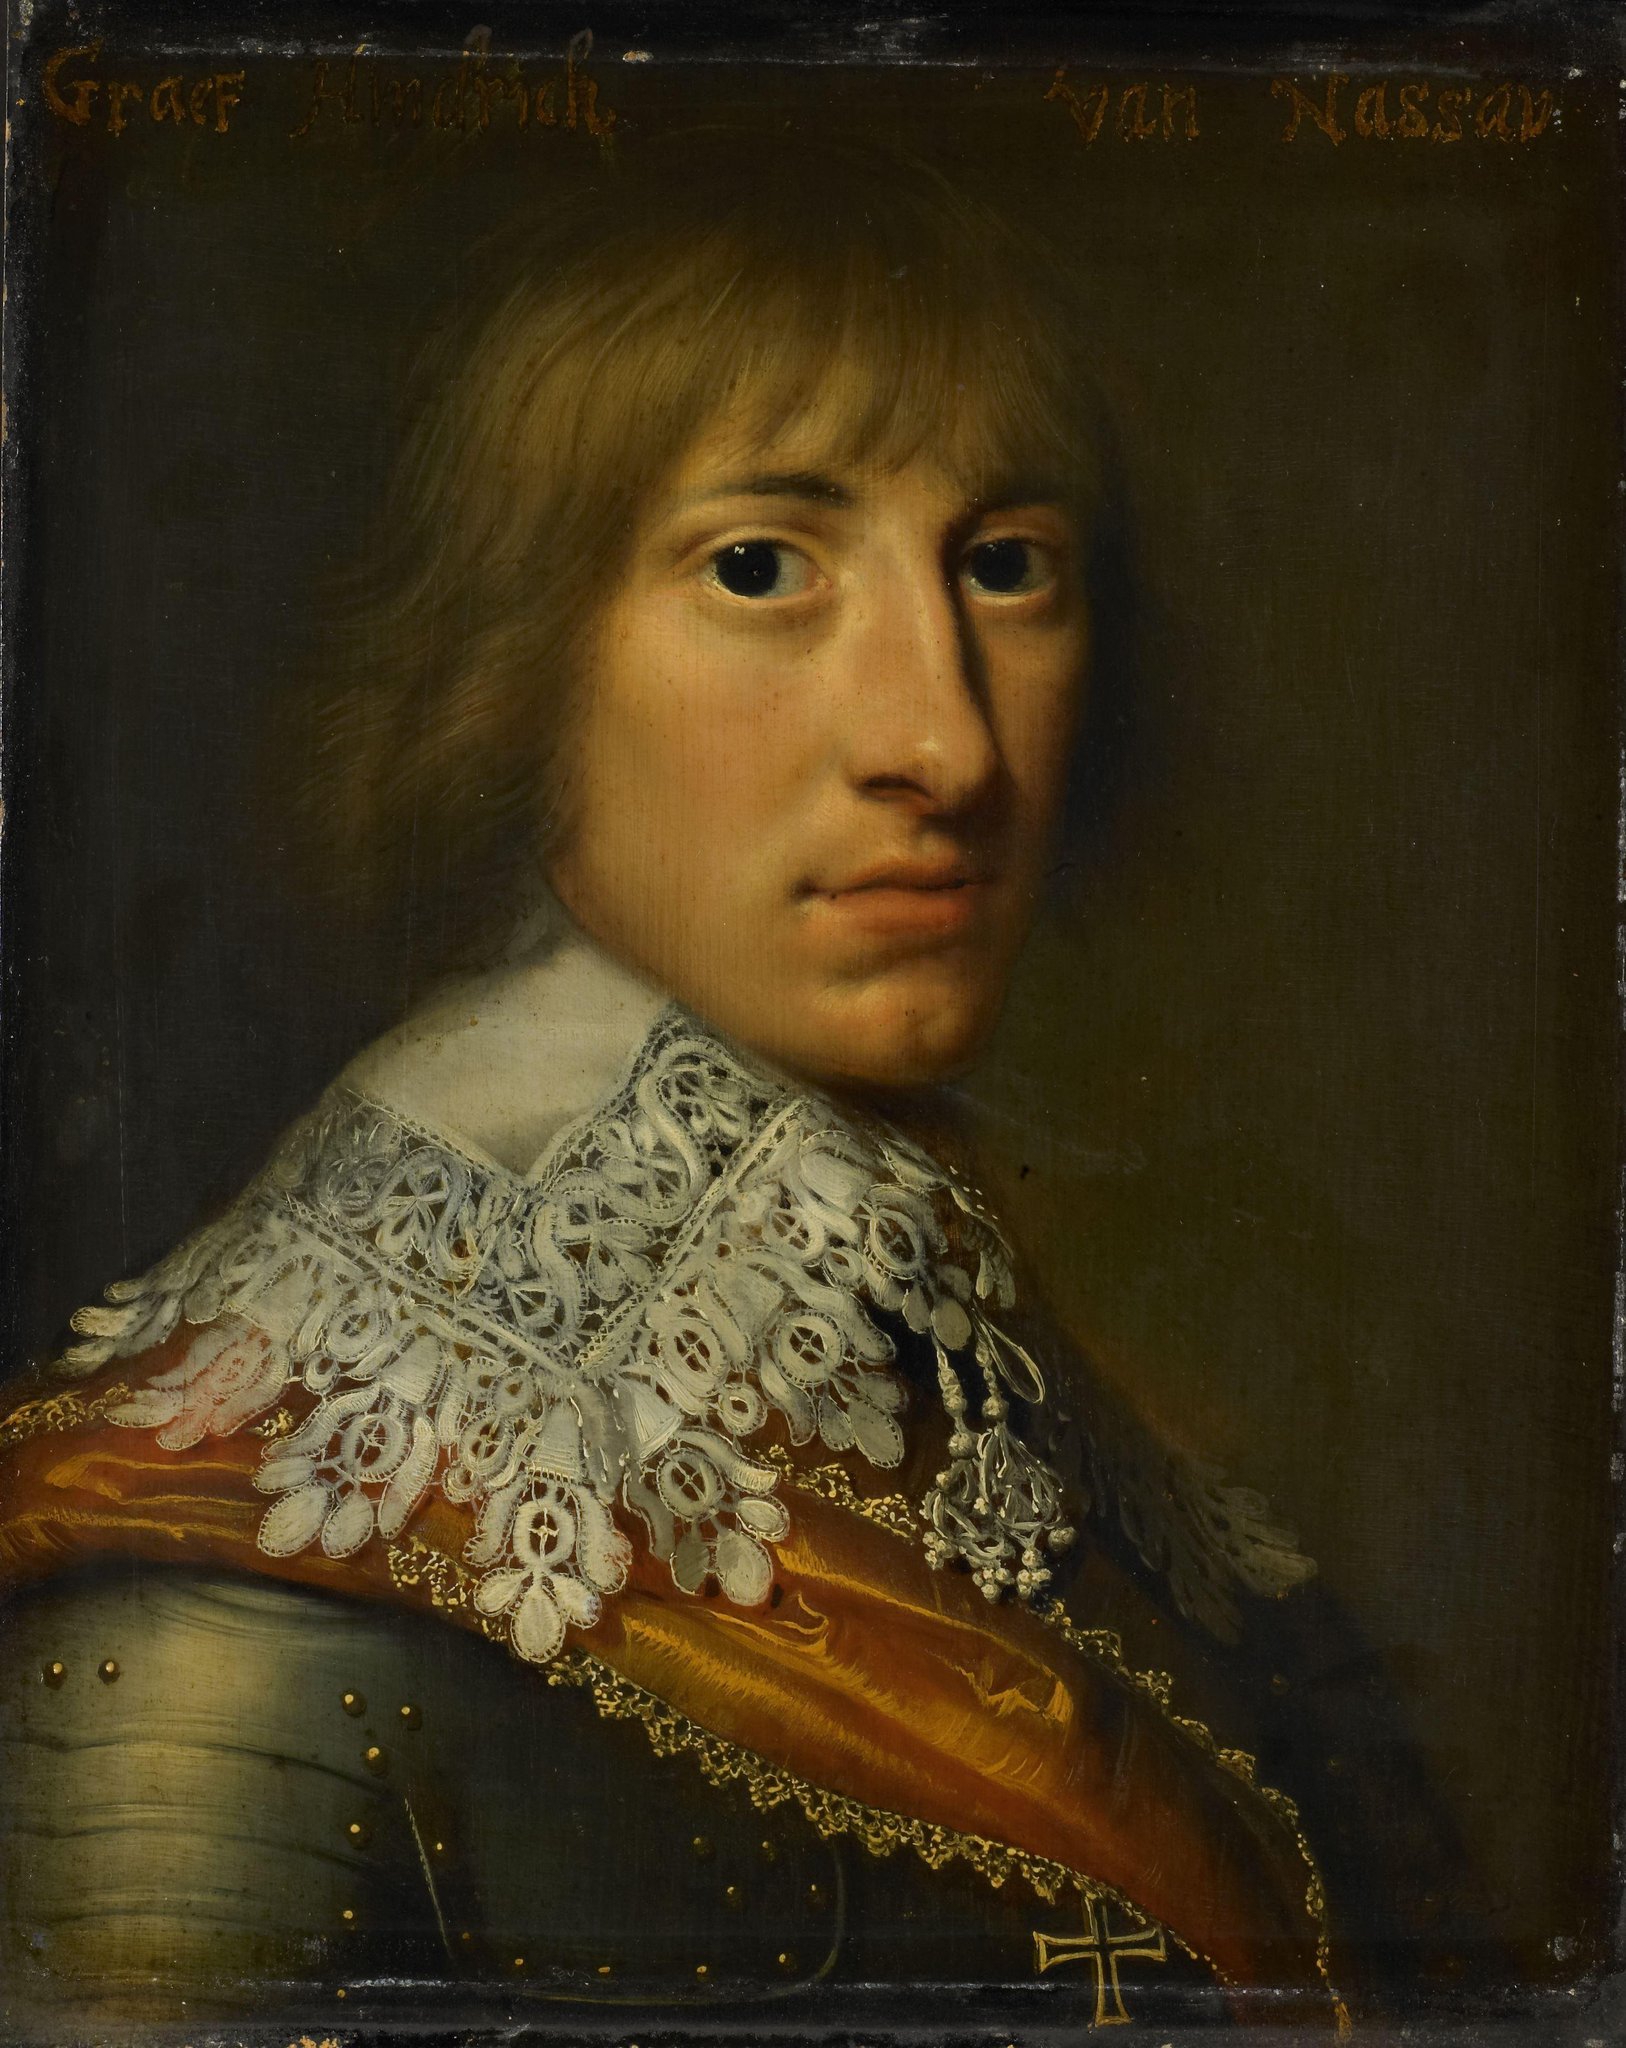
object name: painting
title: Portrait of Hendrik Casimir I (1612-40), Count of Nassau-Dietz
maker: wybrand de geest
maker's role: draughtsman, painter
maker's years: 1592-1665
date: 1632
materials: oil, panel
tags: arnhem, hendrik casimir i graaf van nassau-dietz, historical persons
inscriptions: inscription, top left and right: ‘GraeF Hindrick van Nassau’, signature, top left, beneath inscription: ‘V. de Geest ƒ’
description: These portraits were originally displayed at Honselaarsdijk, the palace built by Stadholder Frederick Henry and his wife Amalia in the 1620s near The Hague. In the style of European courts of the day, one of the palace rooms was lined with portraits of ancestors, relatives and celebrities past and present. Many of these personalities played a role in the Eighty Years War: members of the Nassau family and other commanders of the Dutch Republic's army, officers of the French and English allies and leading Spanish generals. A remarkable aspect is the number of foreigners who fought for the Dutch. The Republic's army enjoyed an international reputation and attracted young noblemen from abroad. For them, the war was a career opportunity.